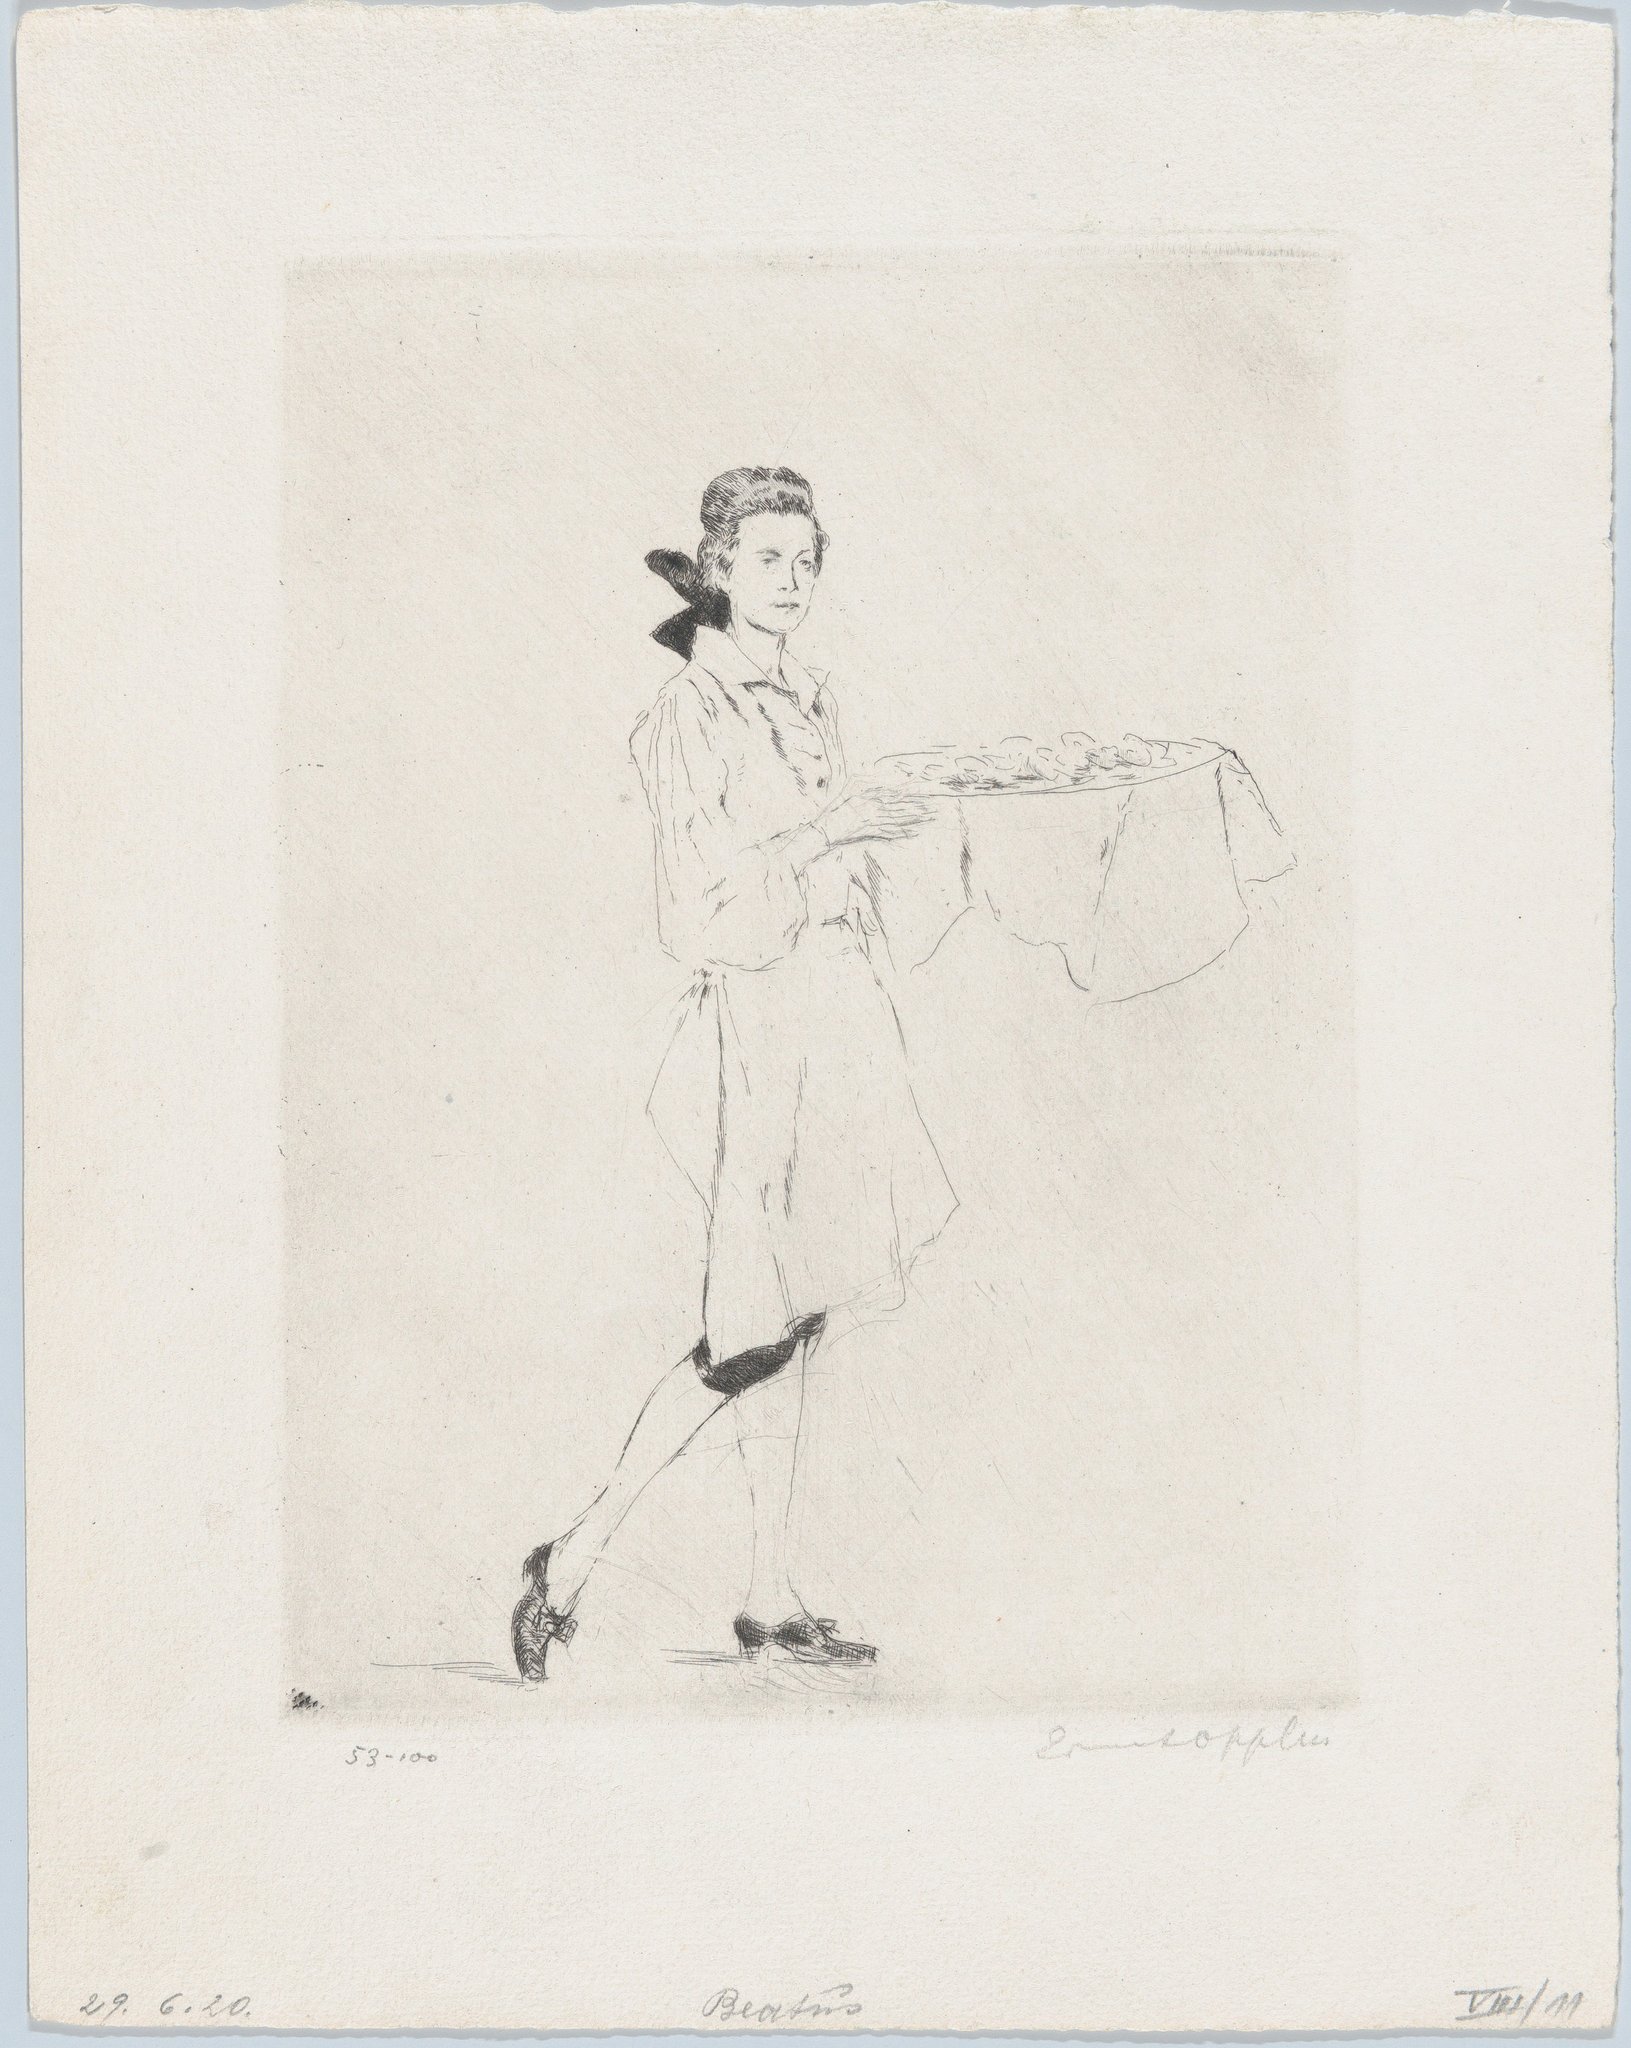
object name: print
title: Beatus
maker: ernst oppler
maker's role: artist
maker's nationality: german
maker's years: 1867-1929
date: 1920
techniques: etching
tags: women,monks